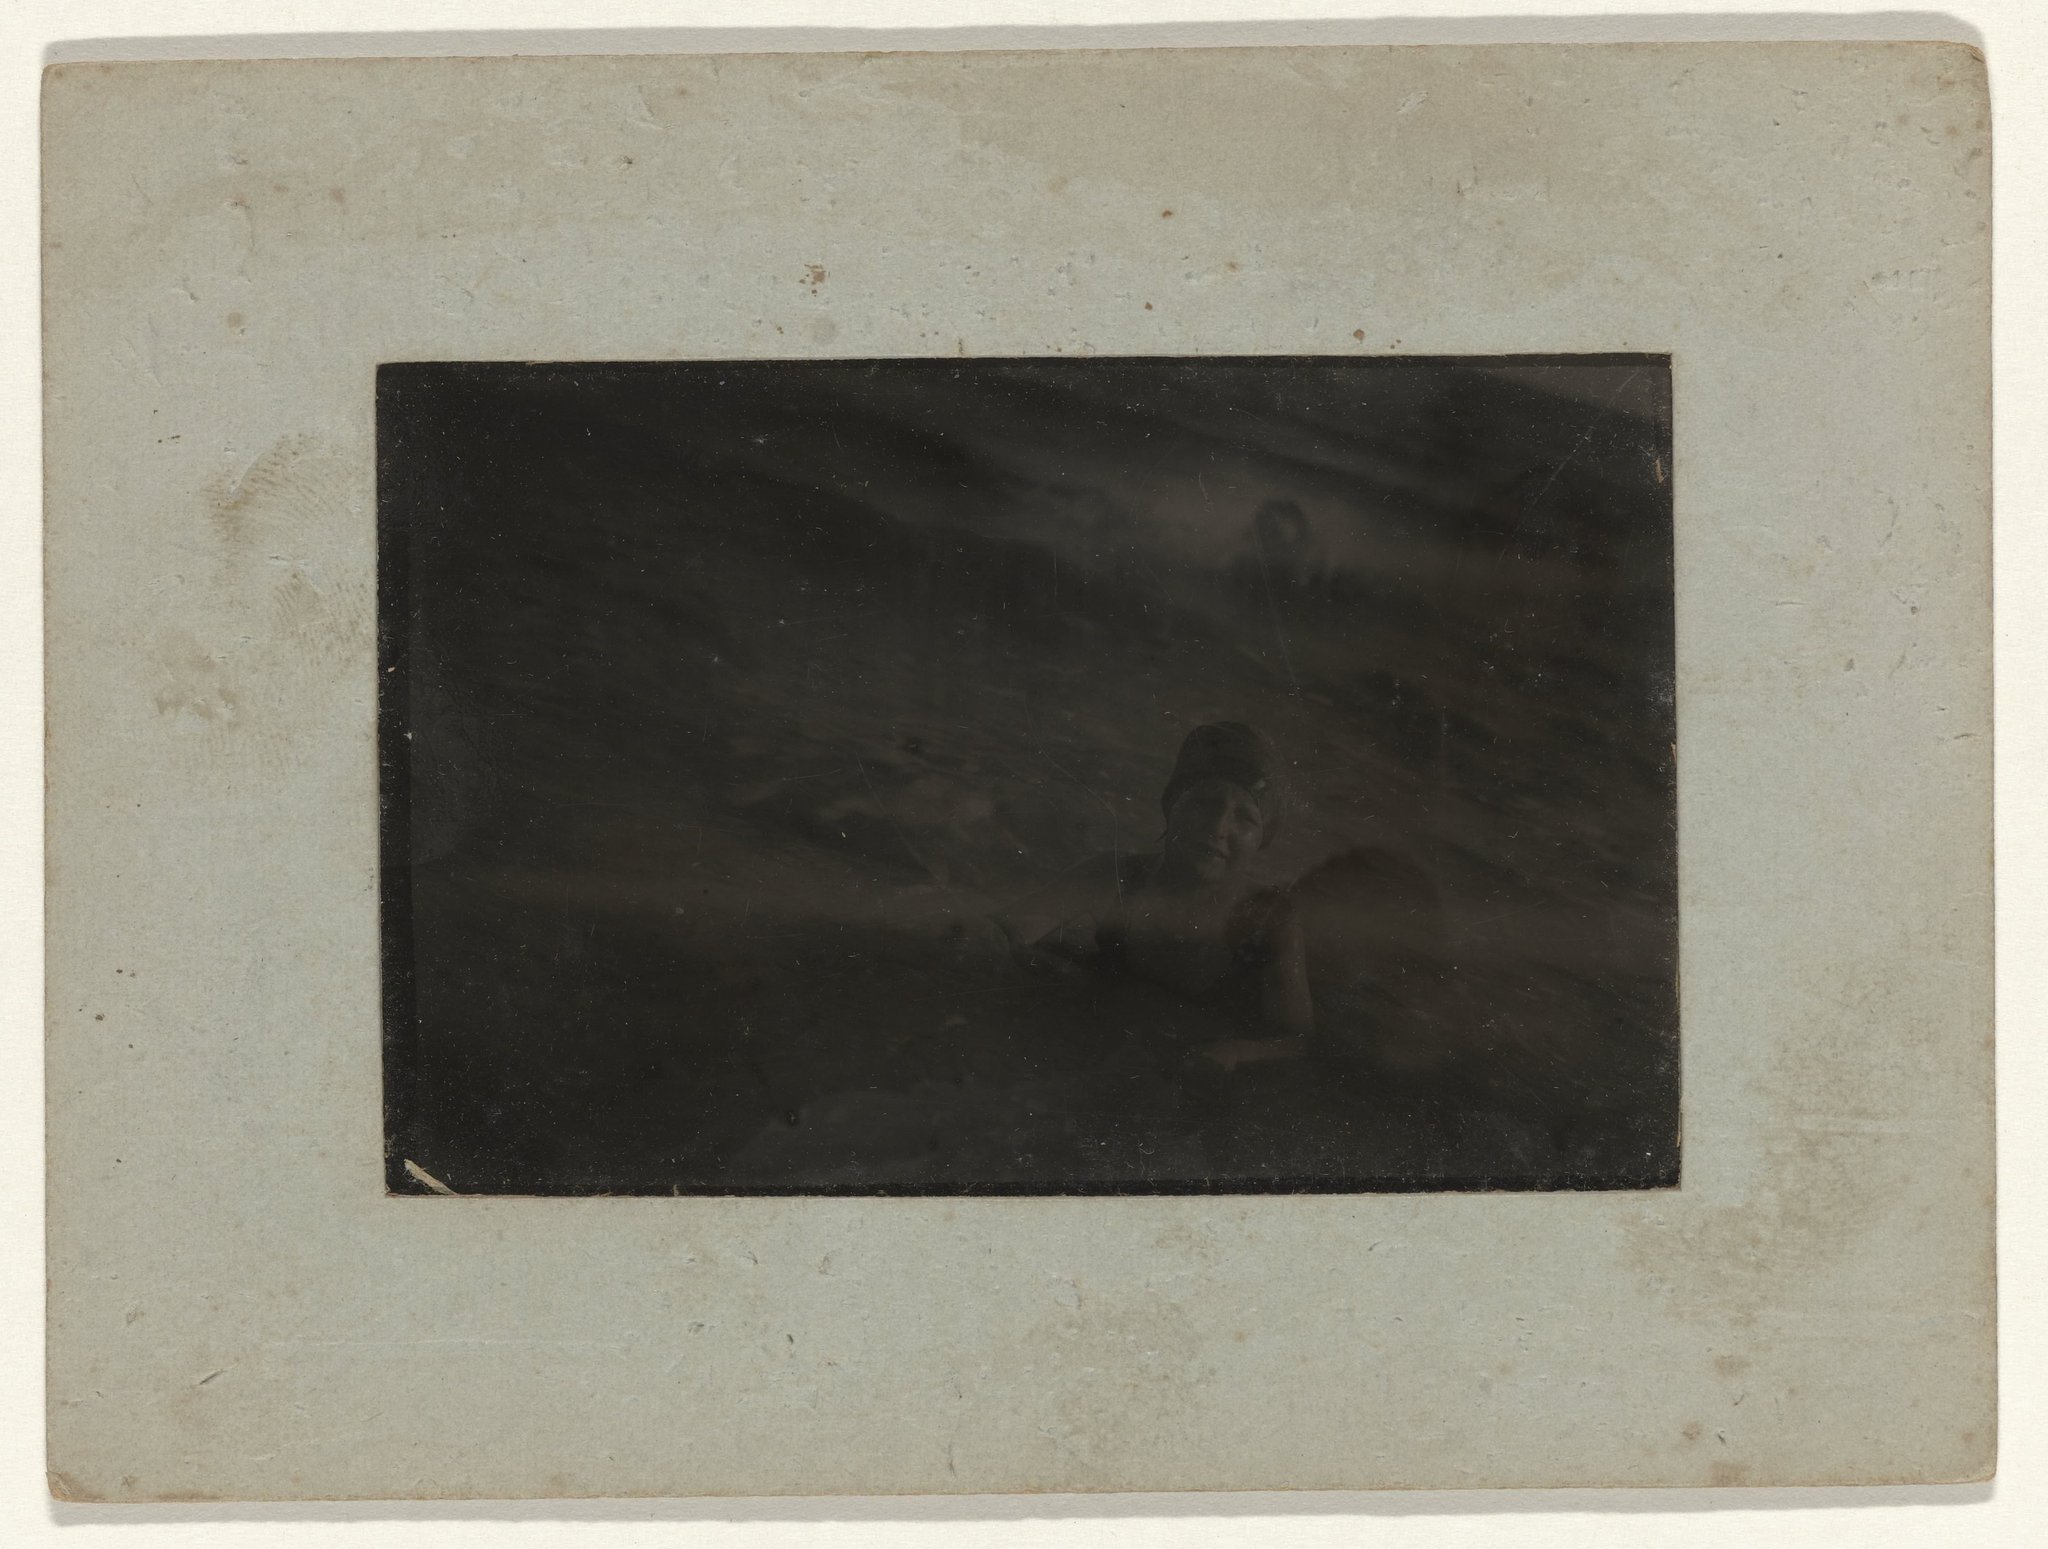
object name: photograph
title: Kind met badmuts in de zee, mogelijk Koosje Ochse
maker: Anonymous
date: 1920-1930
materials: cardboard, iron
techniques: ferrotyping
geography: valkeveen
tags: child, girl (child between toddler and youth), head-gear: cap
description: Portret van een kind met badmuts in de zee (bij het strand bij Valkeveen?).